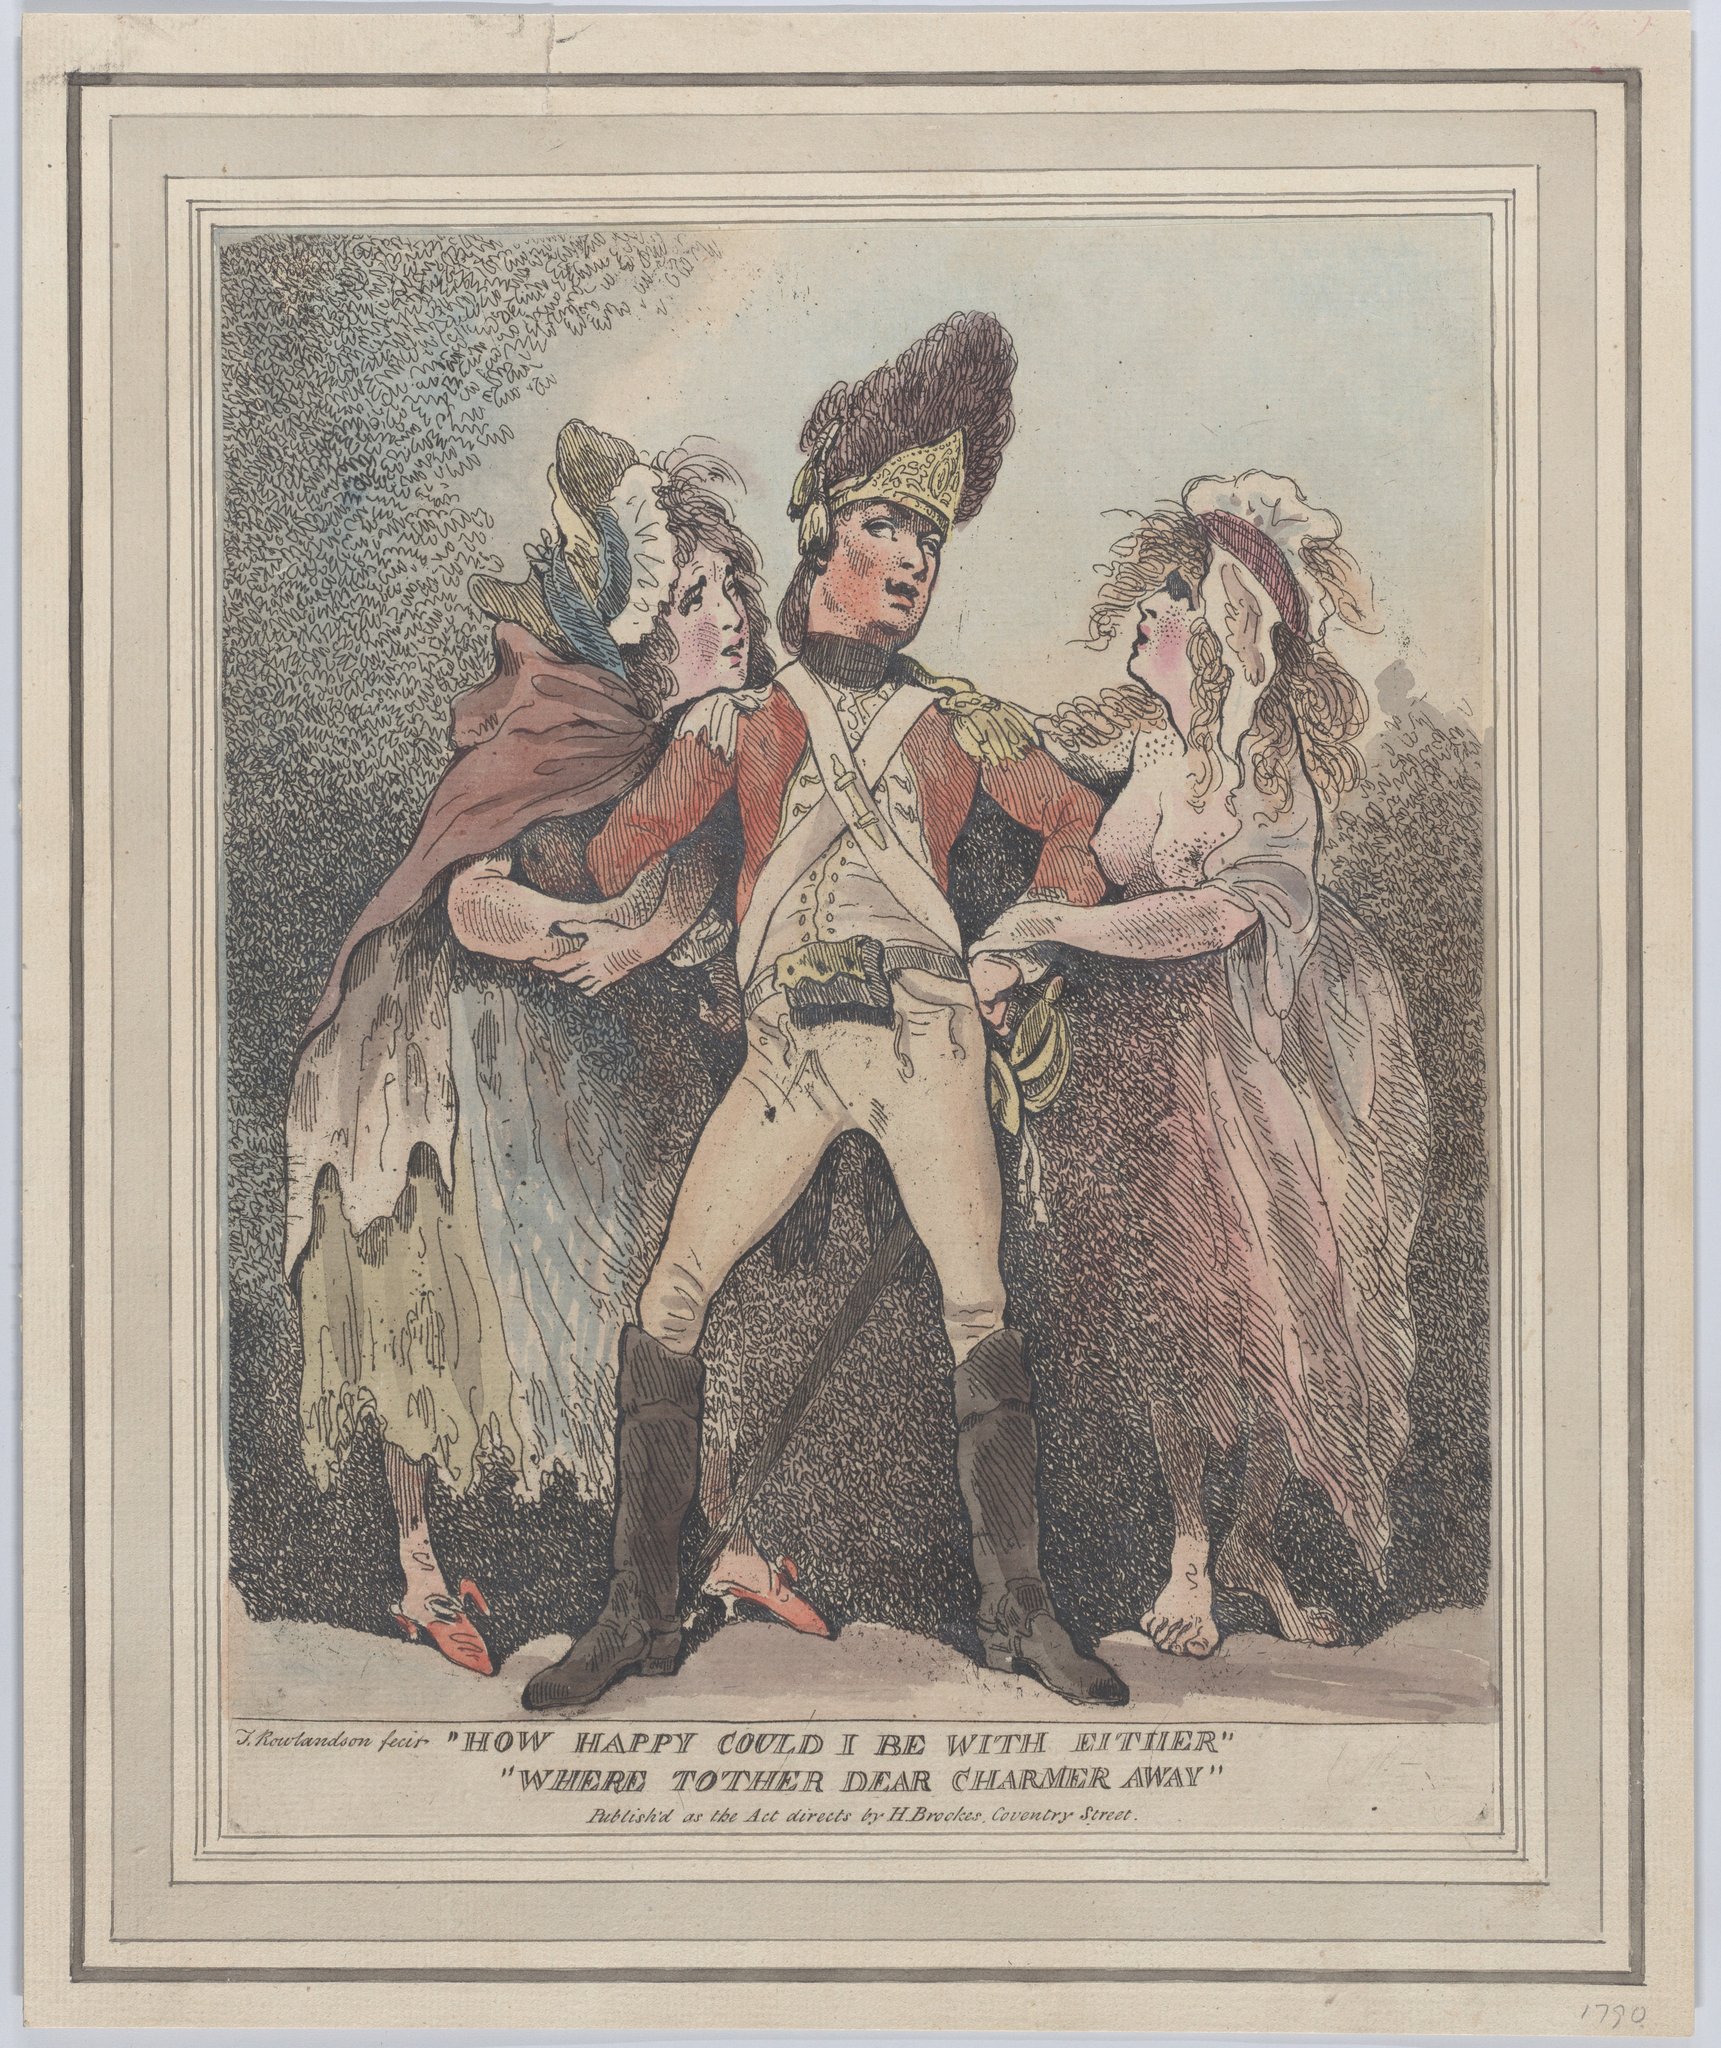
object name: print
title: How Happy Could I Be With Either, Were t'Other Dear Charmer Away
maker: thomas rowlandson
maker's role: artist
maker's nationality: british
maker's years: 1757-1827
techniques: etching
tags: satire,soldiers,men,women